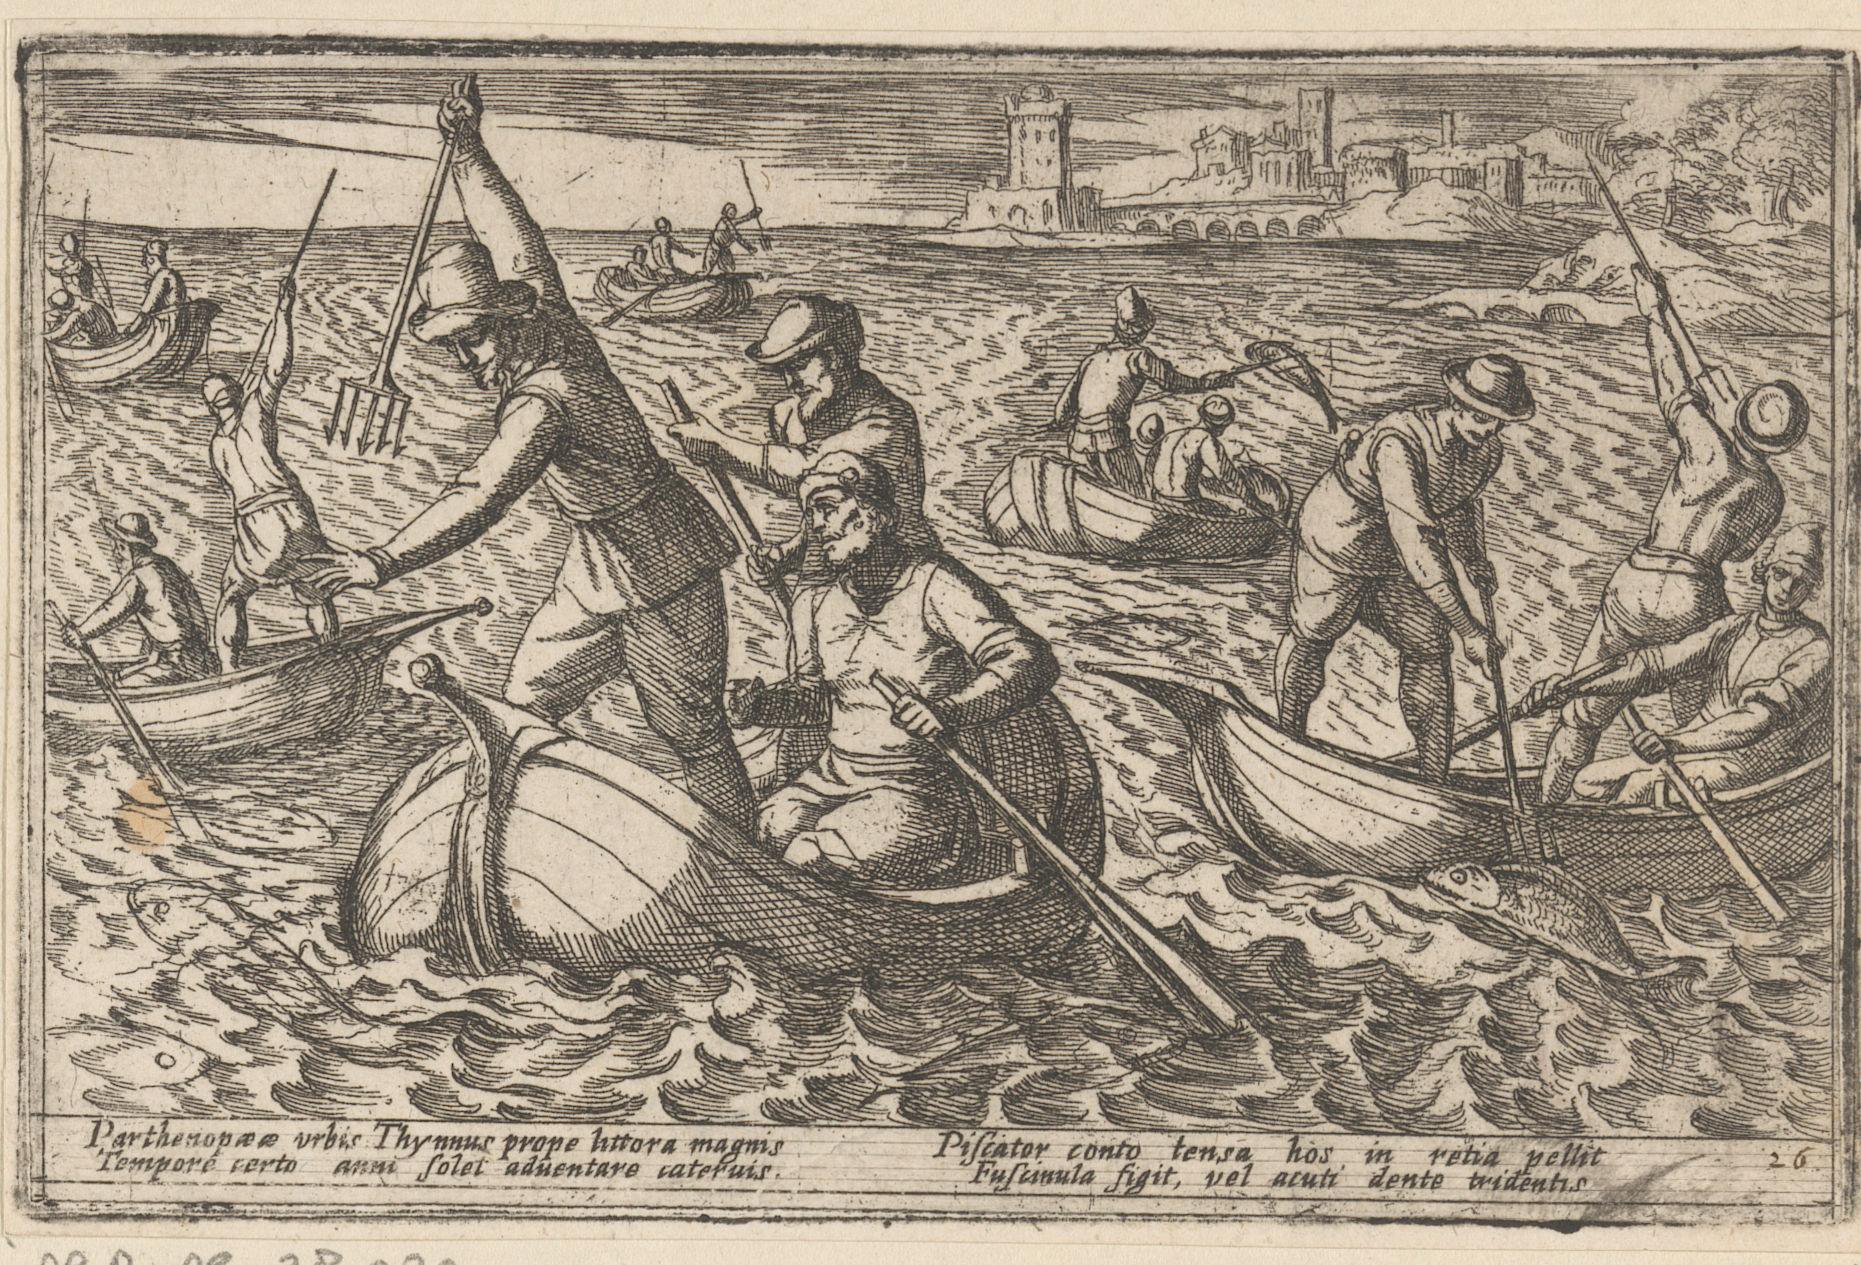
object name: print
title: Venationes Ferarum, Avium, Piscium Pugnae bestiariorum: et mutuae bestiarum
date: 1602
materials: paper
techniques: etching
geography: rome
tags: hunter, hunters hunting (n.b.: in 1988-1990 this notation denoted the concept of 43c11421 'hunters resting during the hunt'), fisherman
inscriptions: collector's mark: Lugt 240, number: ‘26’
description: Vissers staand op roeibootjes proberen tonijn te vangen met behulp van spiezen. Tekst in het Latijn in ondermarge.